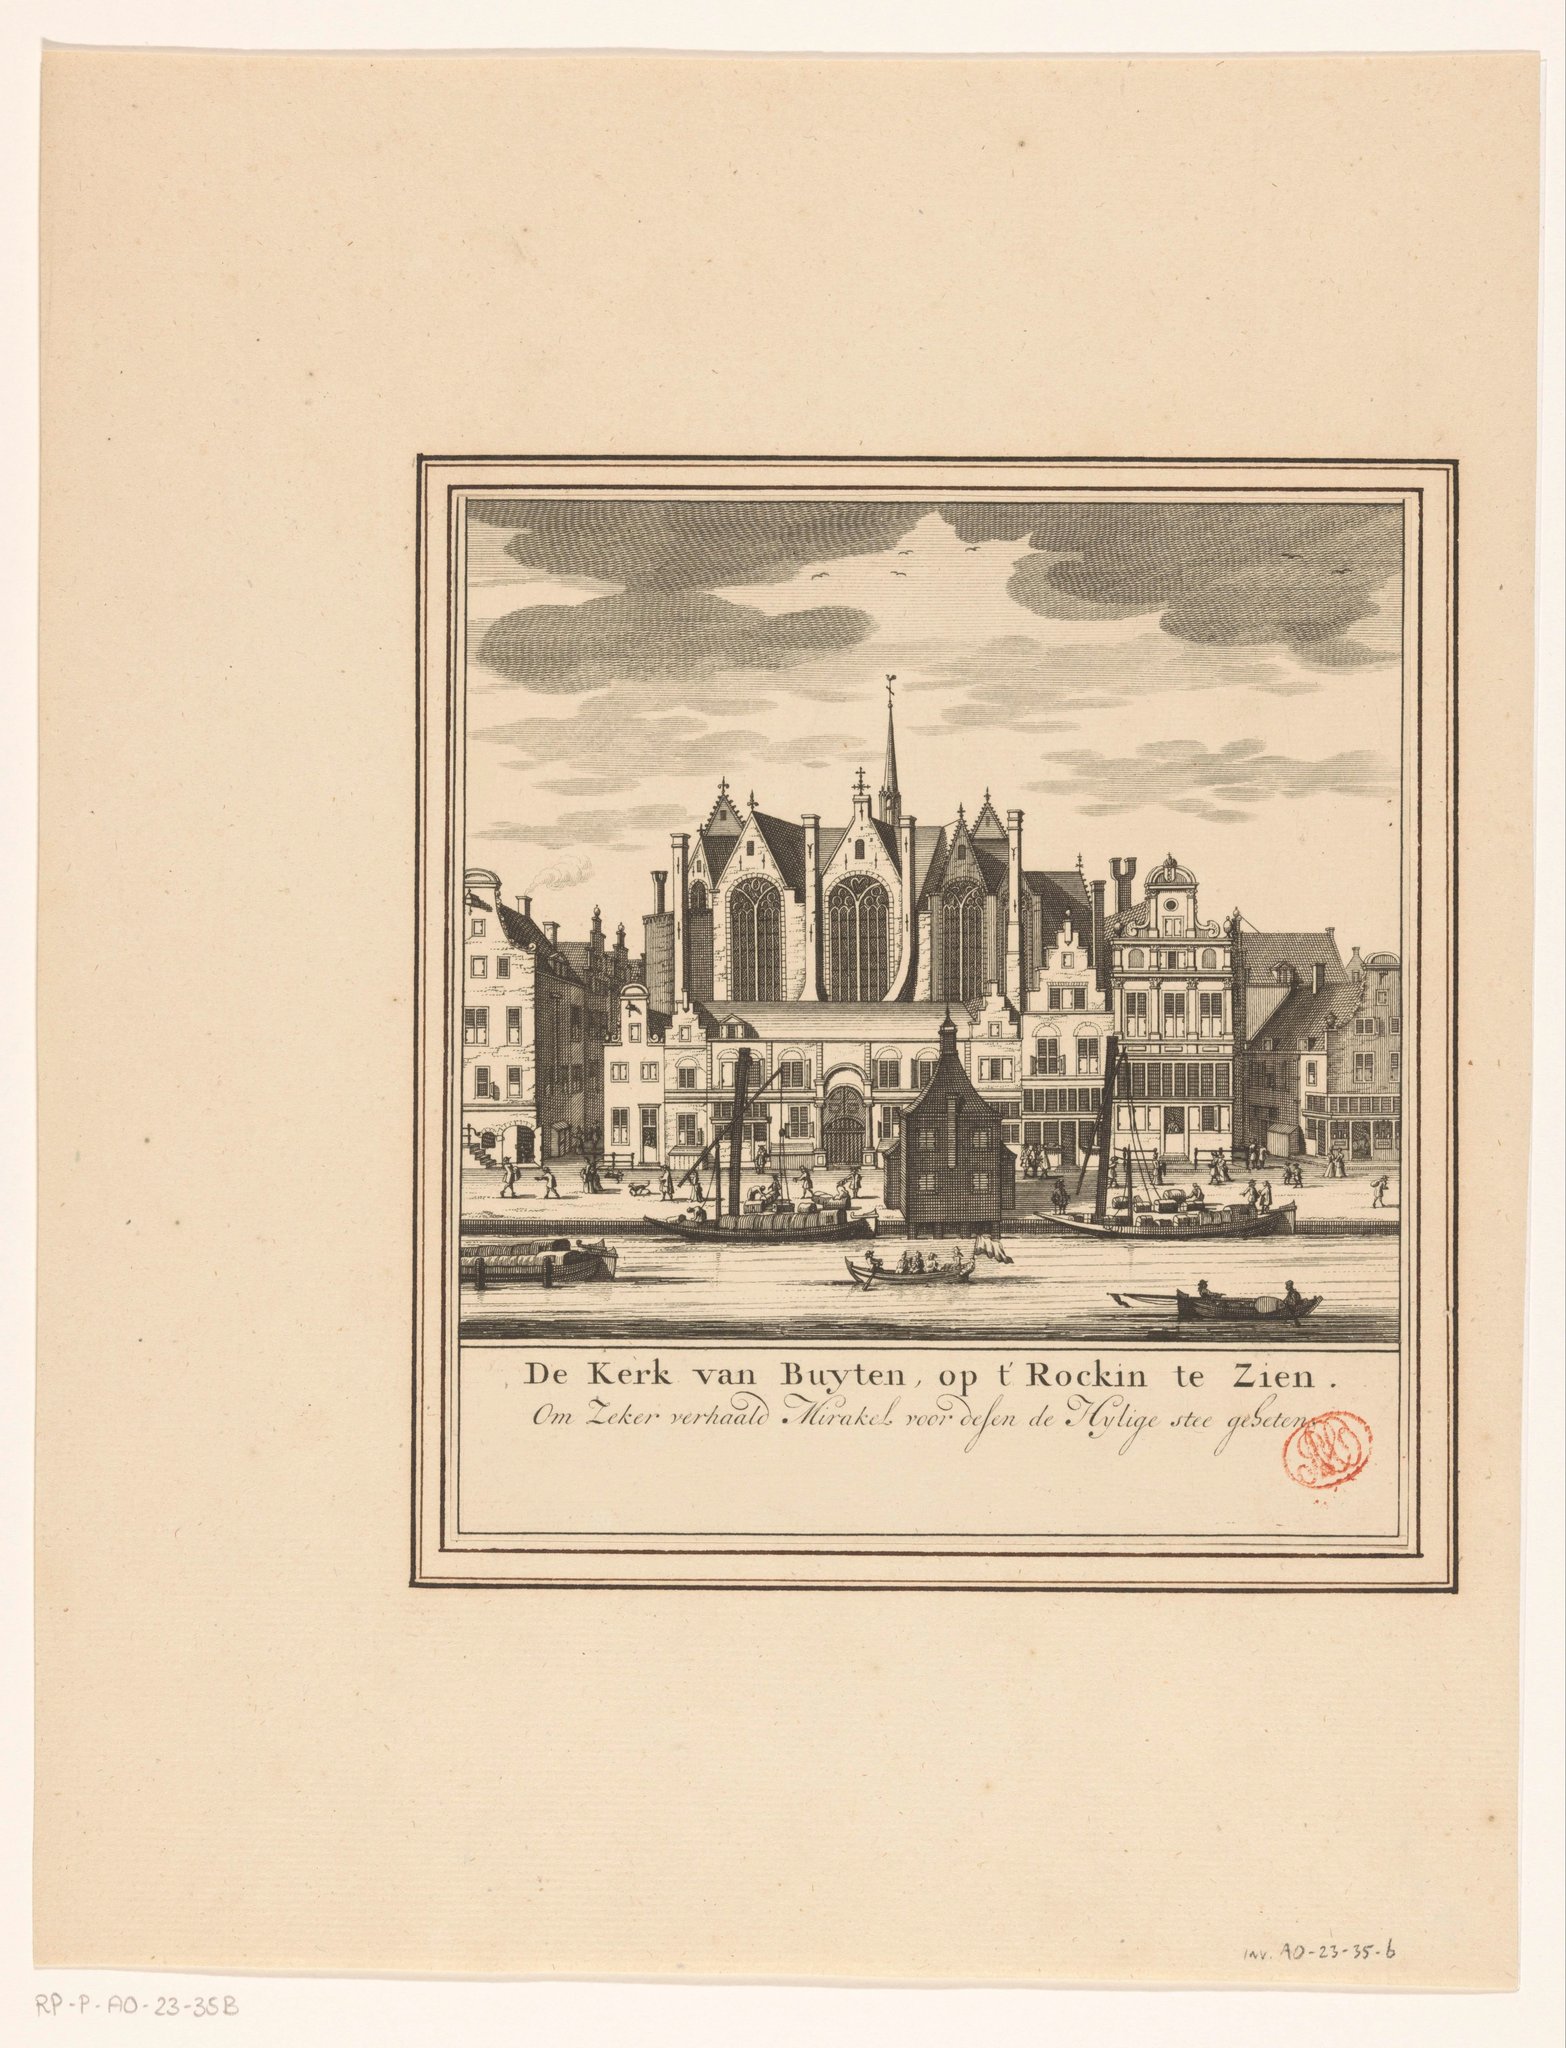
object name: print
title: De Kerk van Buyten, op t' Rockin te Zien. Om Zeker verhaald Mirakel voor desen de Hylige stee geheten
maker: daniël stopendaal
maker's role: print maker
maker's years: 1672-1726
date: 1685-1726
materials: paper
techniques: engraving, etching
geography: amsterdam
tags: church (exterior) - qq - small church, chapel, street (+ city(-scape) with figures, staffage)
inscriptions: collector's mark: Lugt 195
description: Is waarschijnlijk oorspronkelijk één van de randprenten van 'Afbeeldinge vande Sitplaatsen inde Nieuwe-zyds Capel' (RP-P-1912-2295) of 'Caart vande Sitplaat-sen inde N.Z. Capel', beide plattegronden van de zitplaatsen in de Heilige Stede (Nieuwezijds Kapel). Daniël Stopendaal staat als prentmaker vermeld op de plattegronden zelf, de randprenten zijn mogelijk ook door hem gemaakt. Zie RP-P-AO-23-35A-1, RP-P-AO-23-36A en RP-P-AO-23-36B voor andere bijhorende randprenten. Zie RP-P-AO-23-57 voor een soortgelijke plattegrond van de Oosterkerk met randprenten.